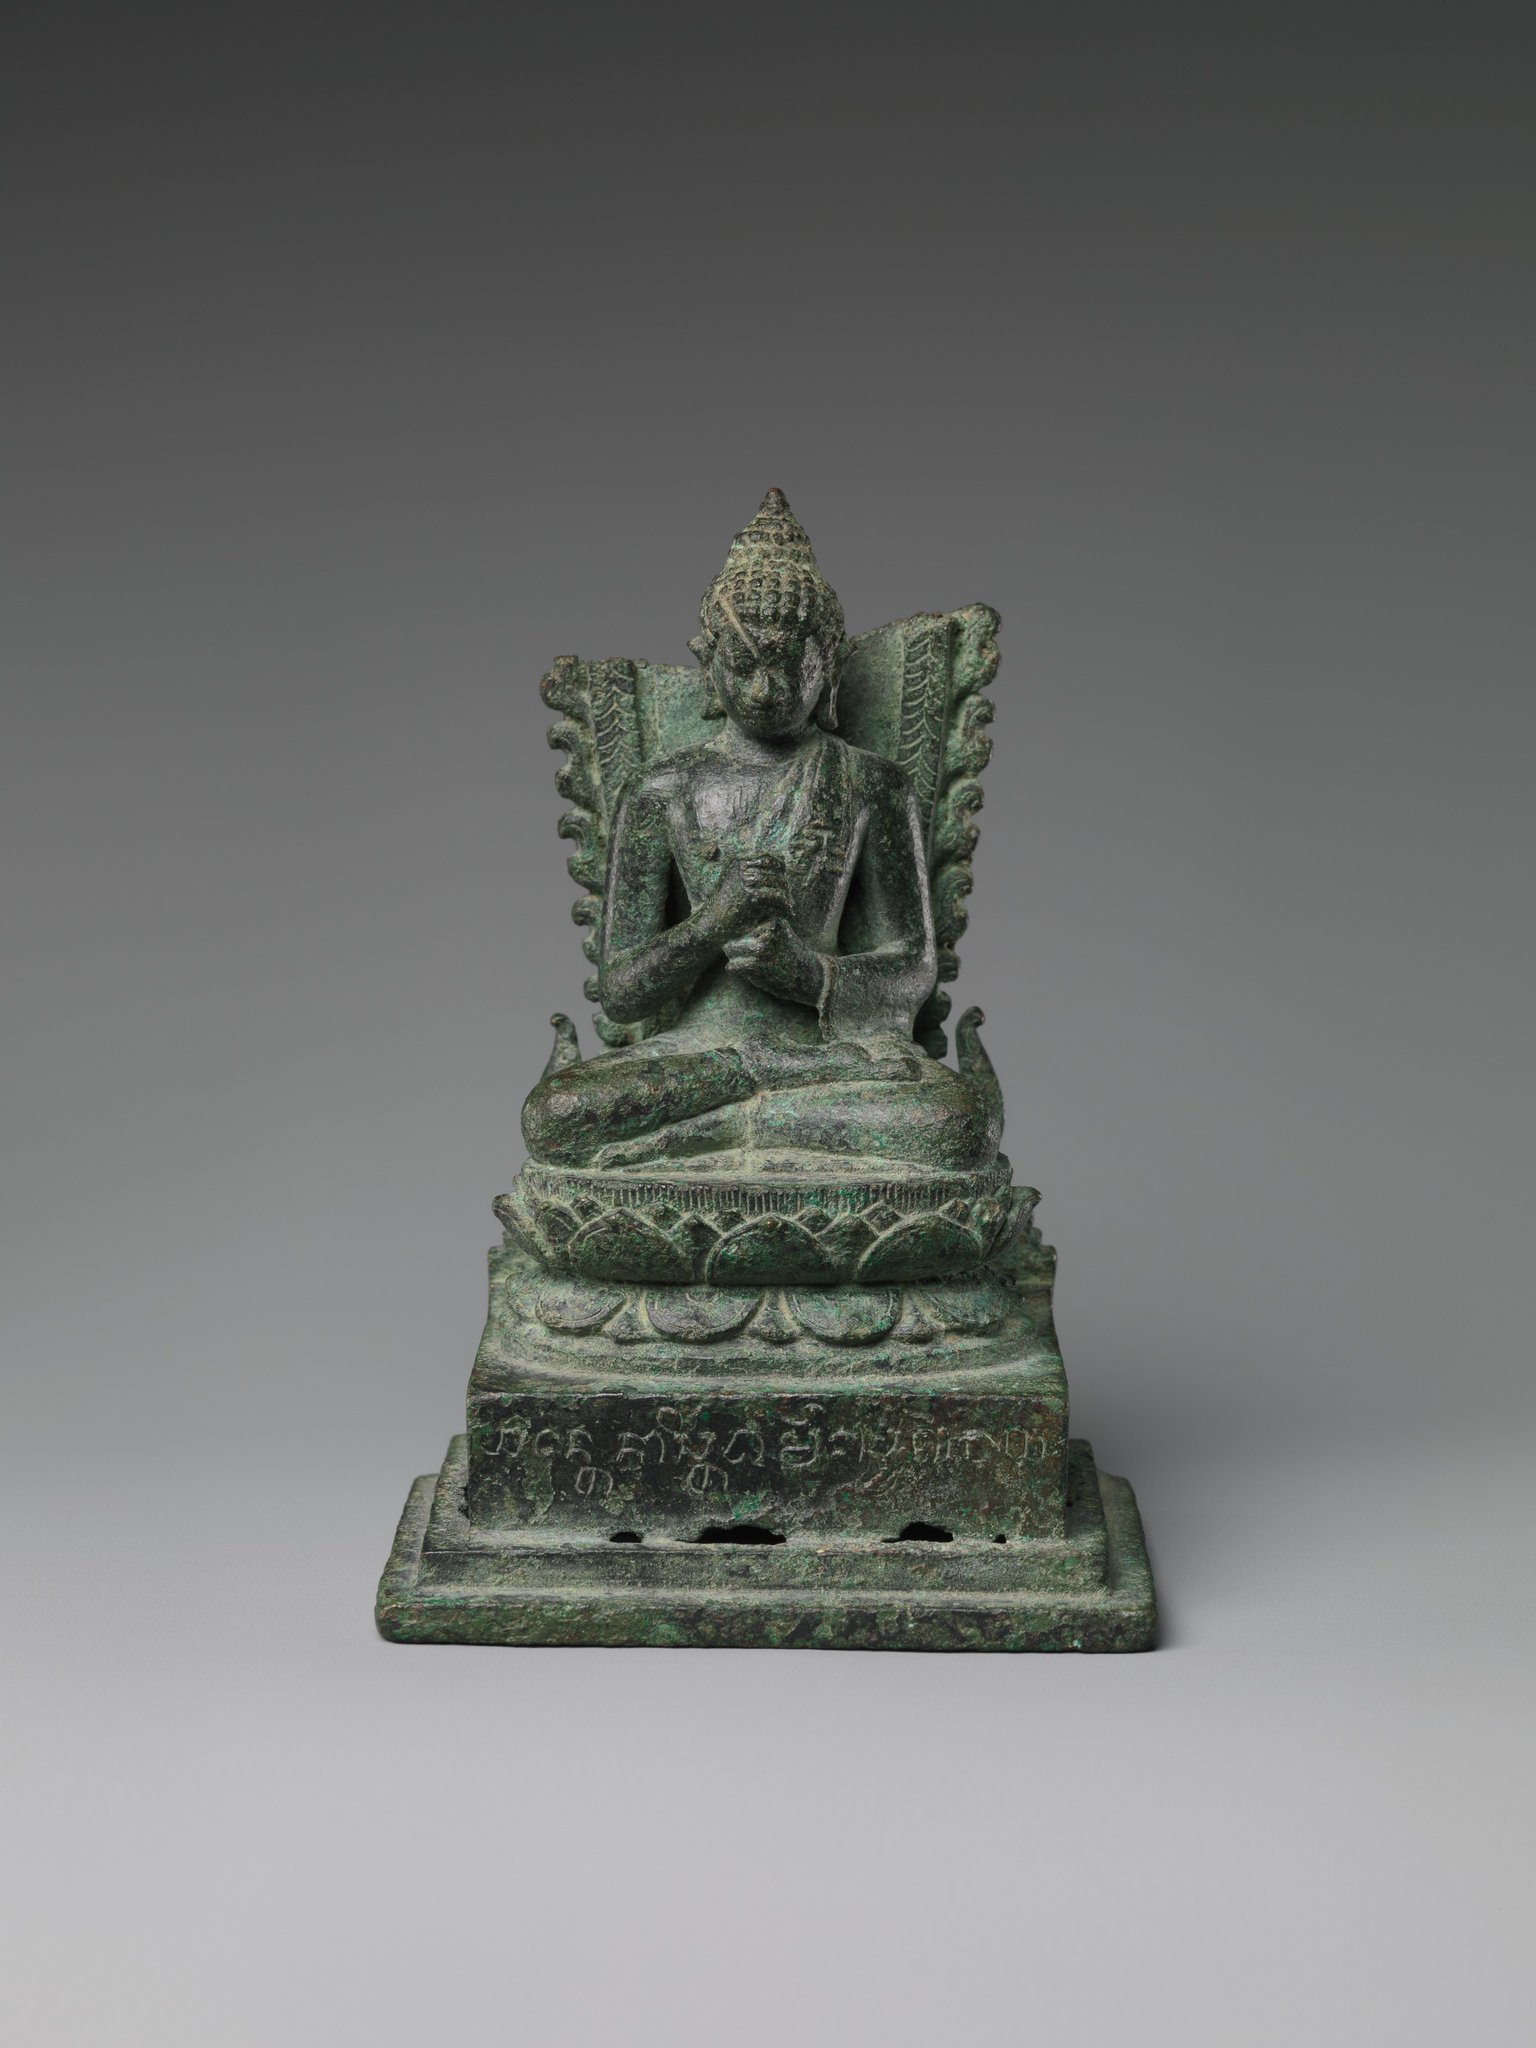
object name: figurine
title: Seated Buddha (With Inscription on Base)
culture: indonesian, javanese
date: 801-900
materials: bronze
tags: buddhism,buddha